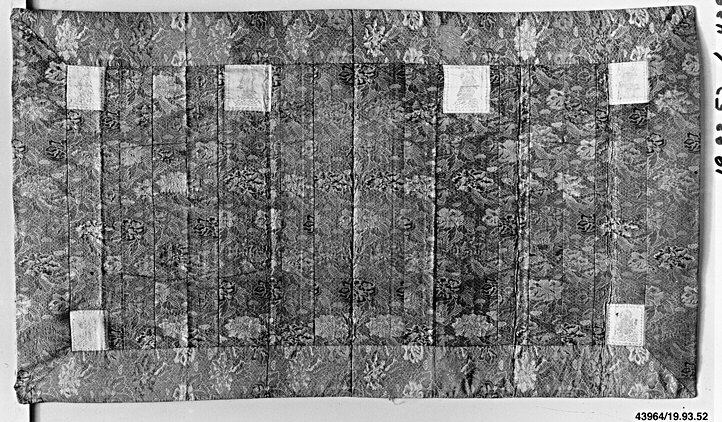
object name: robe, priest's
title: Priest's Robe (Shichijō)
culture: japanese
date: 1625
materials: metal thread, silk